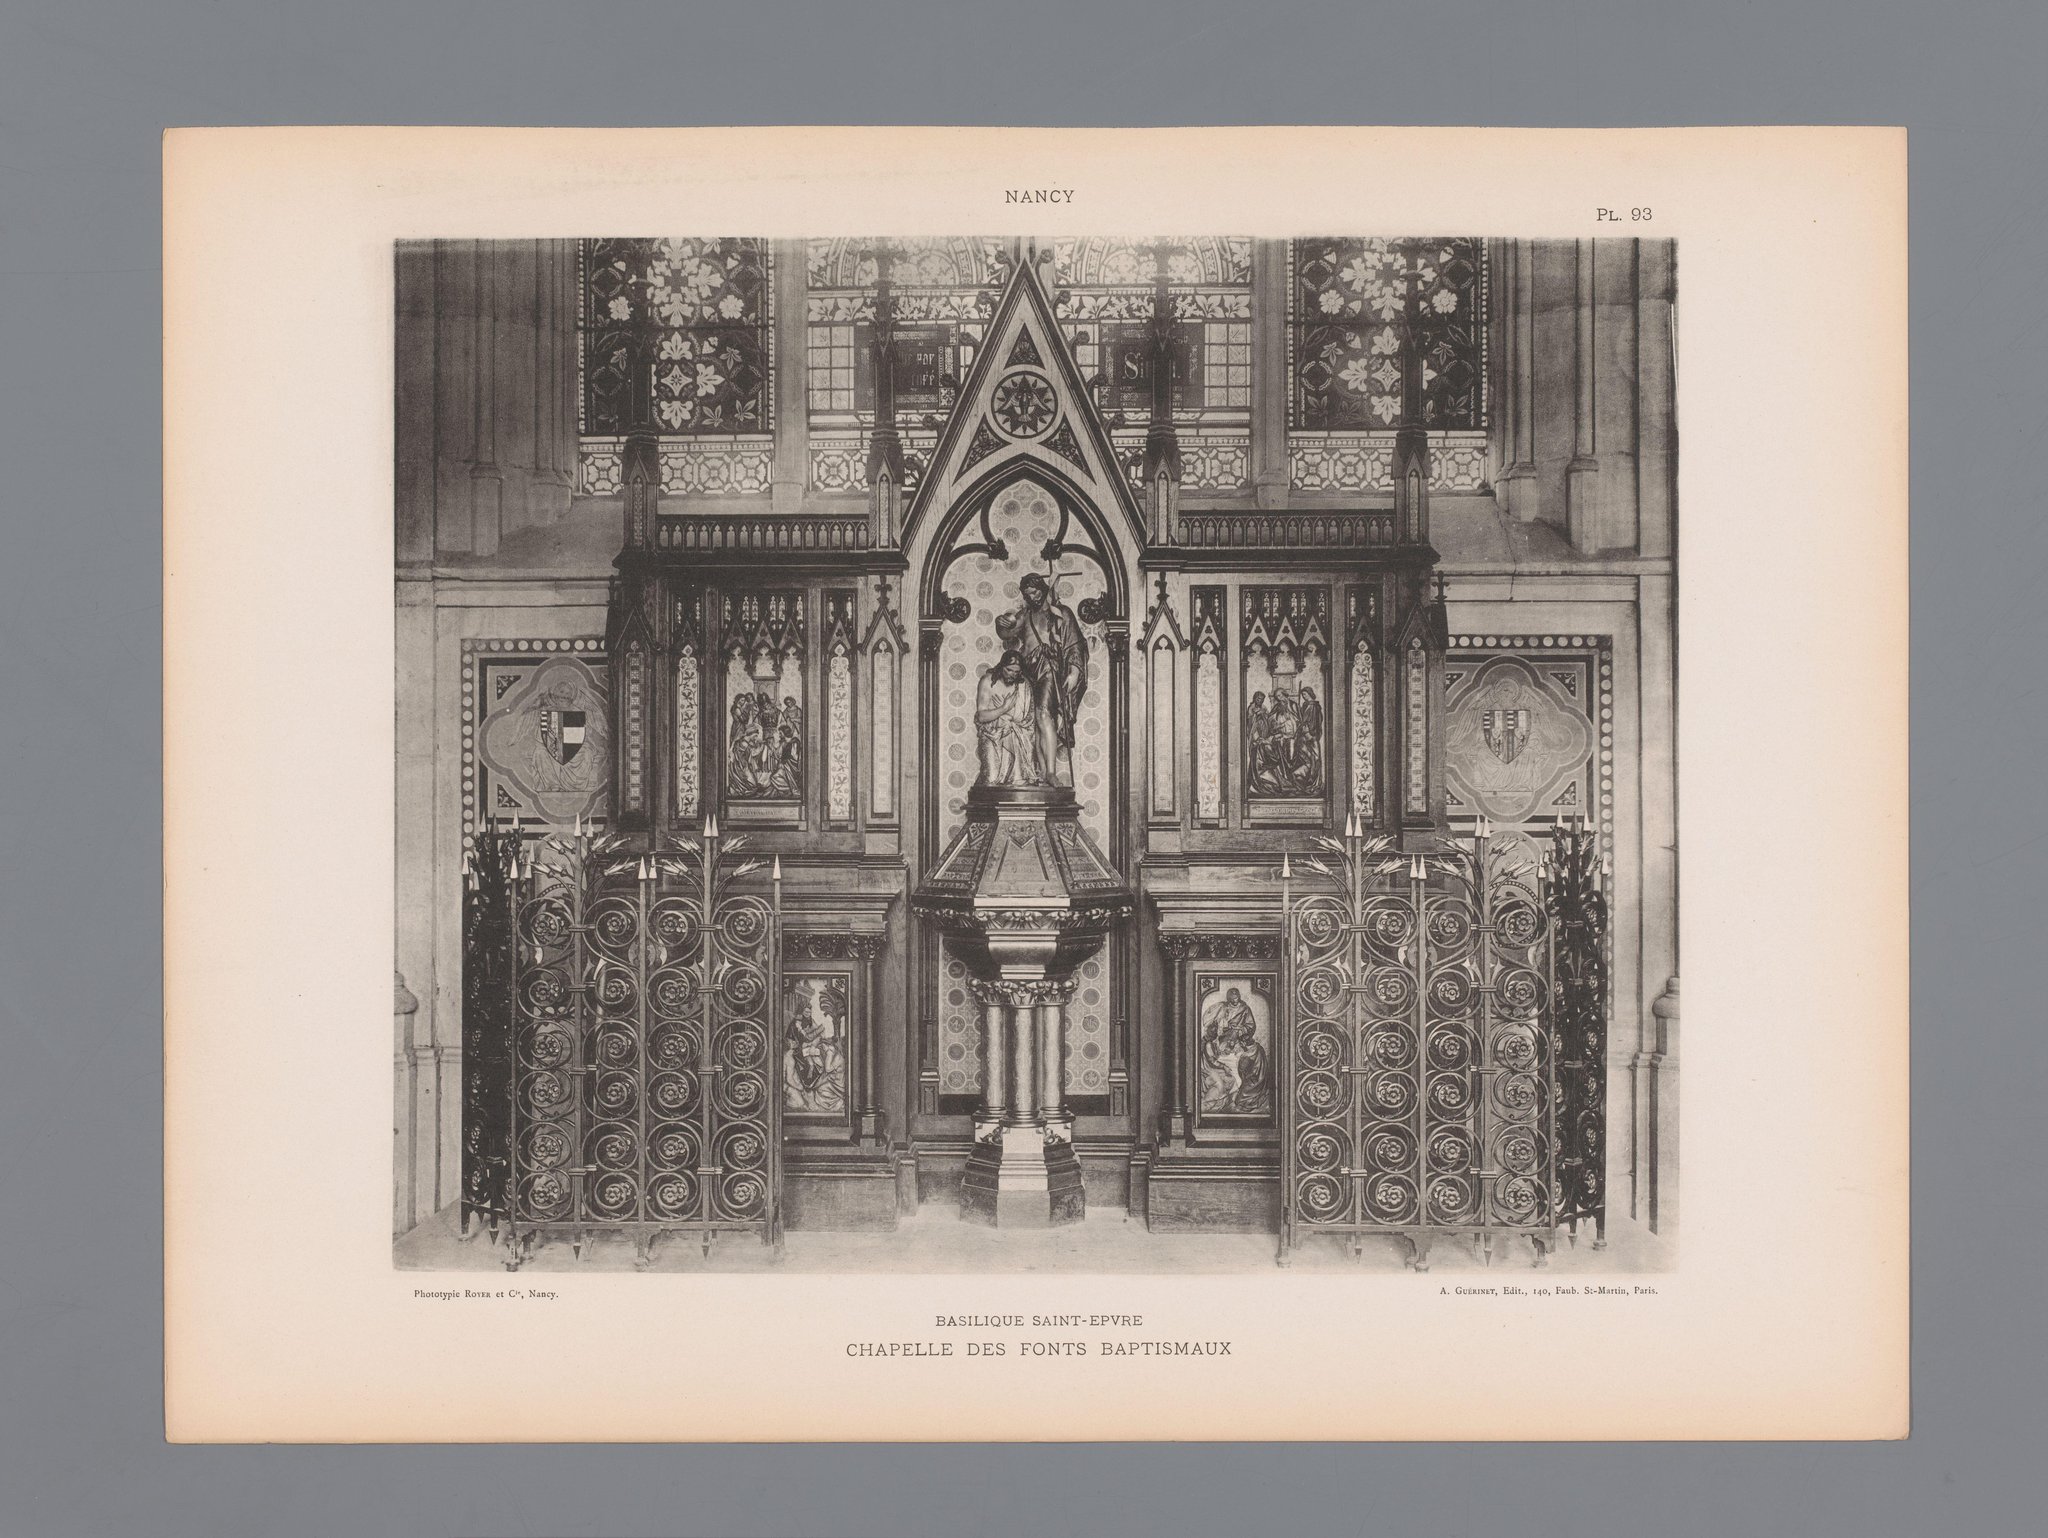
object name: photomechanical print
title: Doopkapel in de Basilique Saint-Epvre te Nancy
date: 1891-1896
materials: paper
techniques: photograph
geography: nancy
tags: interior of church, baptismal font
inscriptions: inscription: ‘Basilique Saint-Epvre/ Chapelle des fonts baptismaux’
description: Deze prent maakt deel uit van een omslag met 103 prenten op 101 bladen en een titelblad.